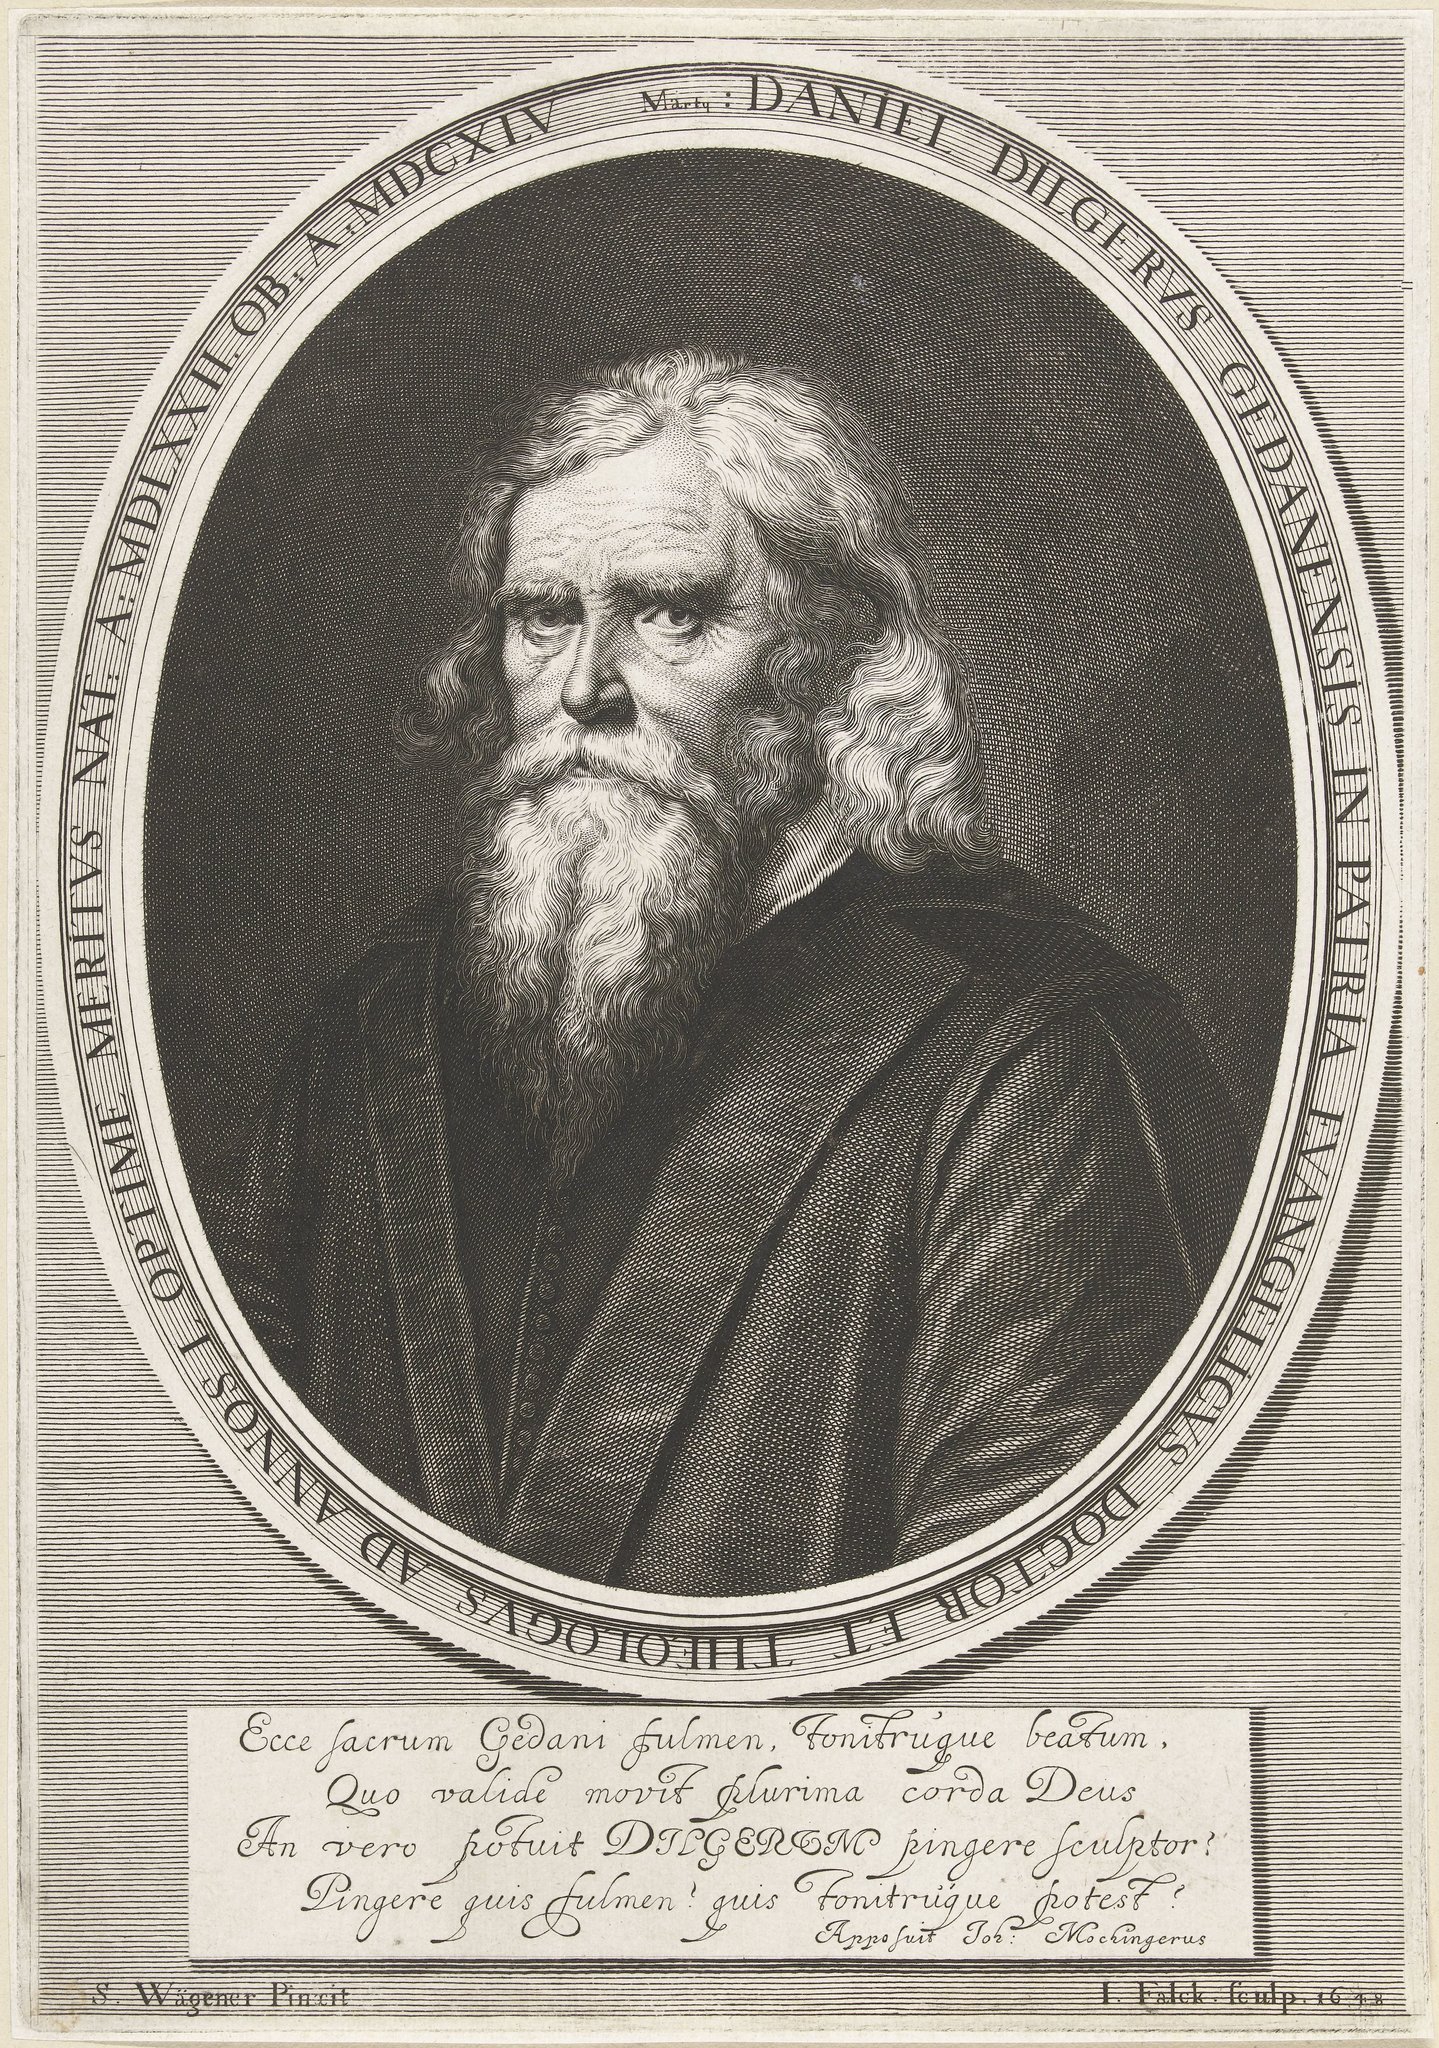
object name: print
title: Portret van Daniel Dilger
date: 1648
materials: paper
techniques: engraving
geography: danzig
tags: poland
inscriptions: collector's mark: Lugt 240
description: Portret van de theoloog Daniel Dilgers, afgebeeld in ovale omlijsting met onderschrift in Latijn.